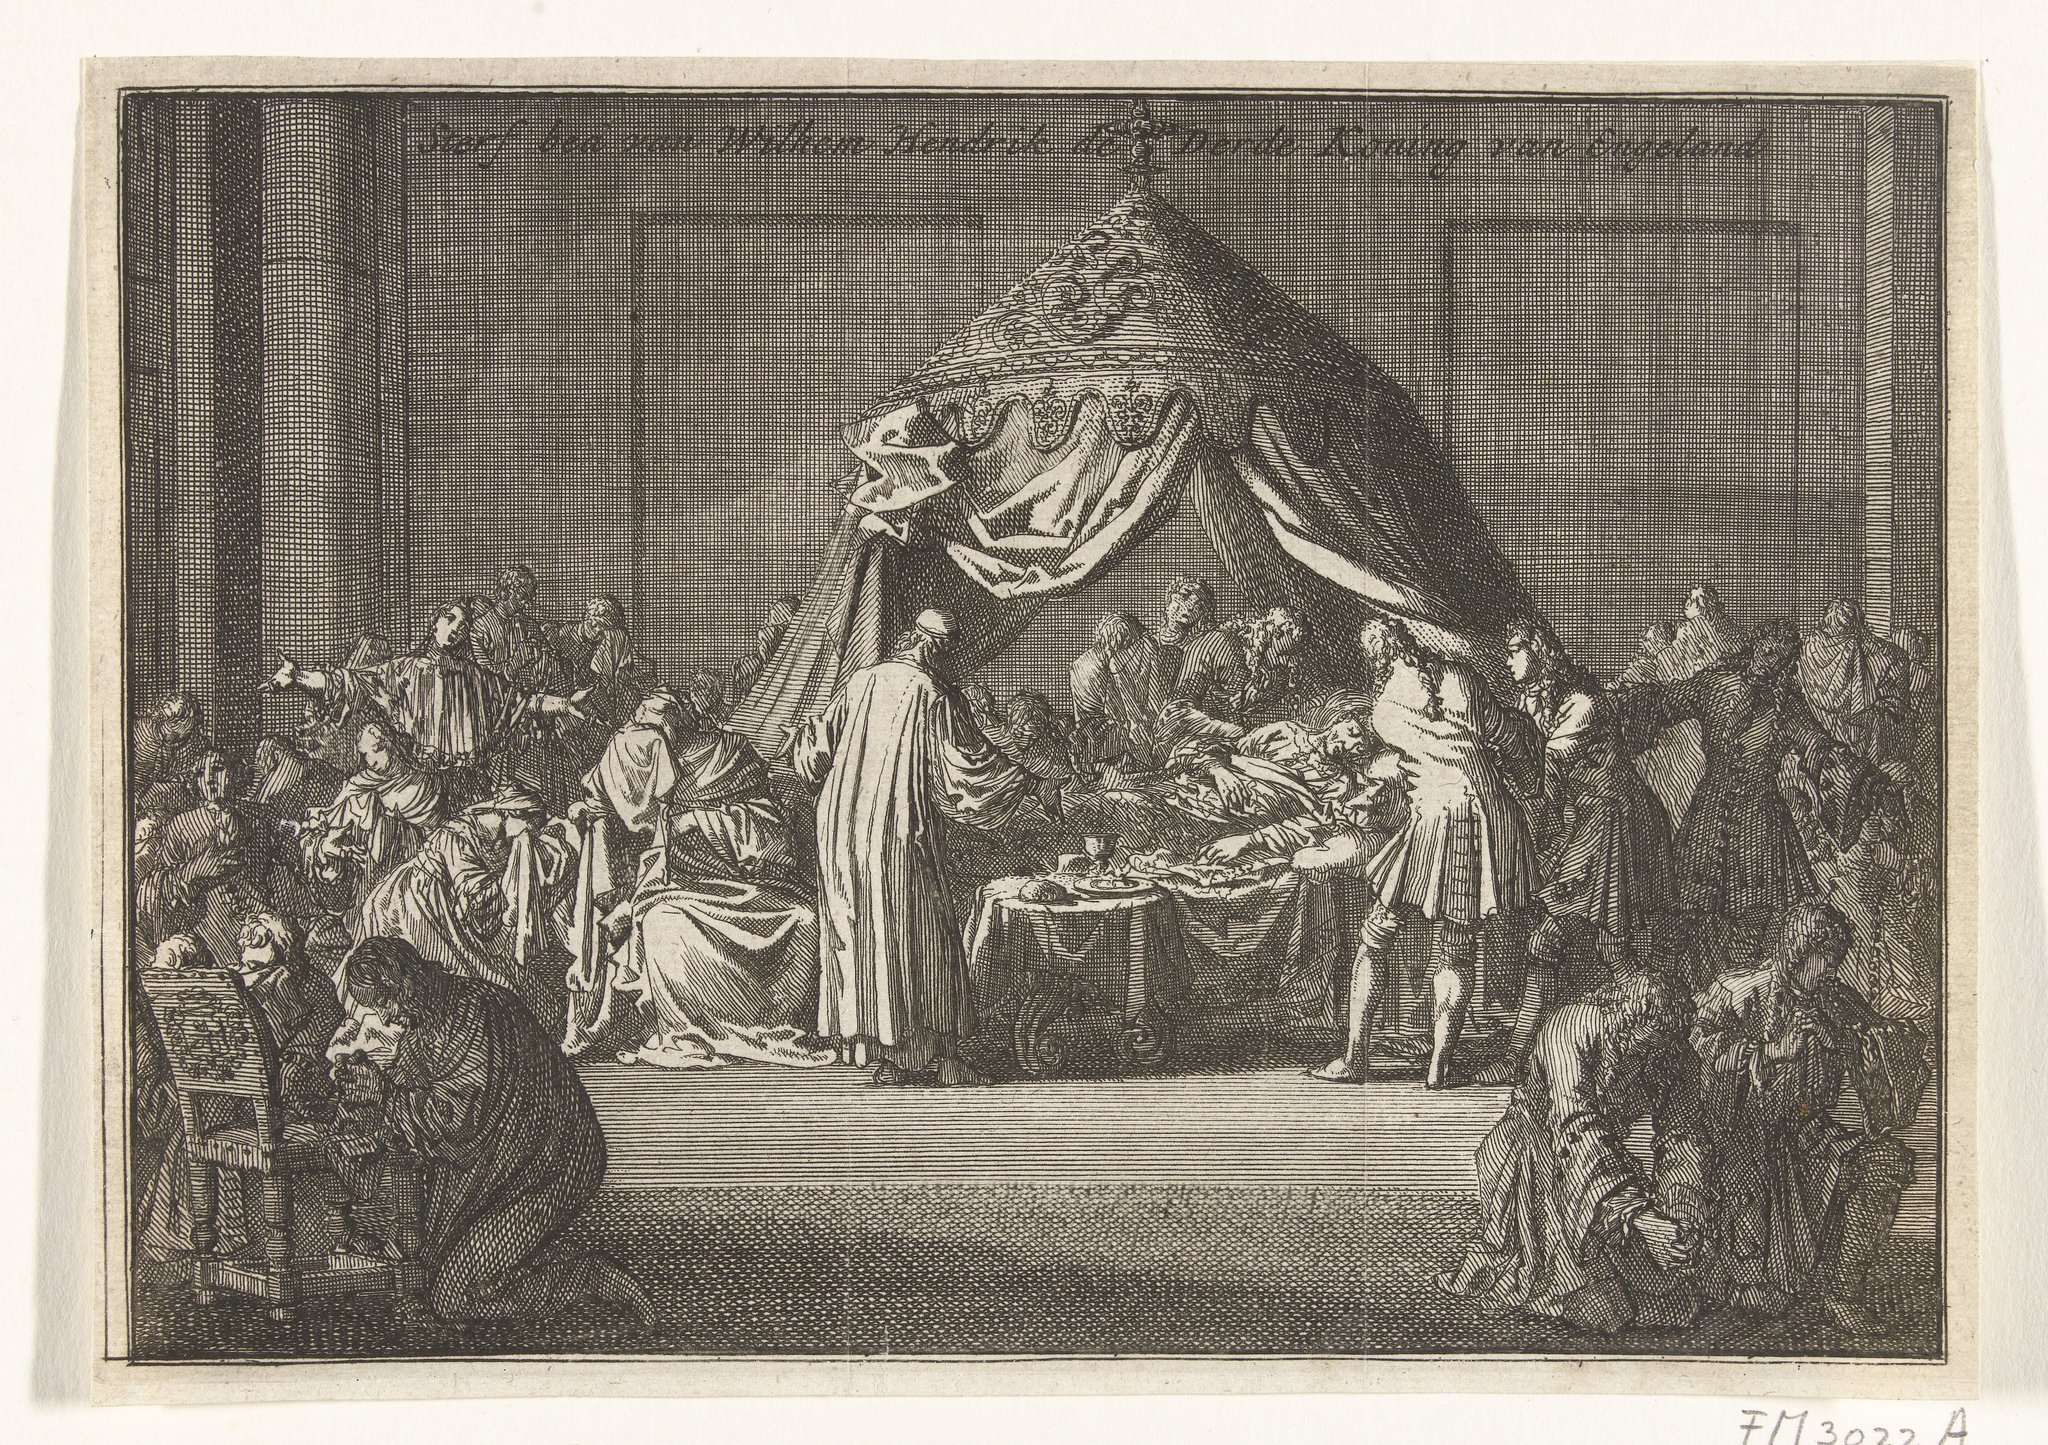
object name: print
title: Sterf bed van Wilhem Hendrik de Derde Koning van Engeland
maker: jan luyken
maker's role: draughtsman, print maker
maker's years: 1649-1712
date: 1702-1703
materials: paper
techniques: etching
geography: northern netherlands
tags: the hague, william iii (prince of orange and king of england, scotland, and ireland), london, anna stuart (koningin van engeland en schotland), deathbed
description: Sterfbed van koning Willem III in het paleis te Londen, 19 maart 1702. De koning overlijdt aan de gevolgen van een val tijdens een jachtpartij op 4 maart. Bij het voeteneind staat de aartsbisschop van Canterbury, links op een stoel de wenende Anna met haar hofdames. Op de voorgrond knielende personen.